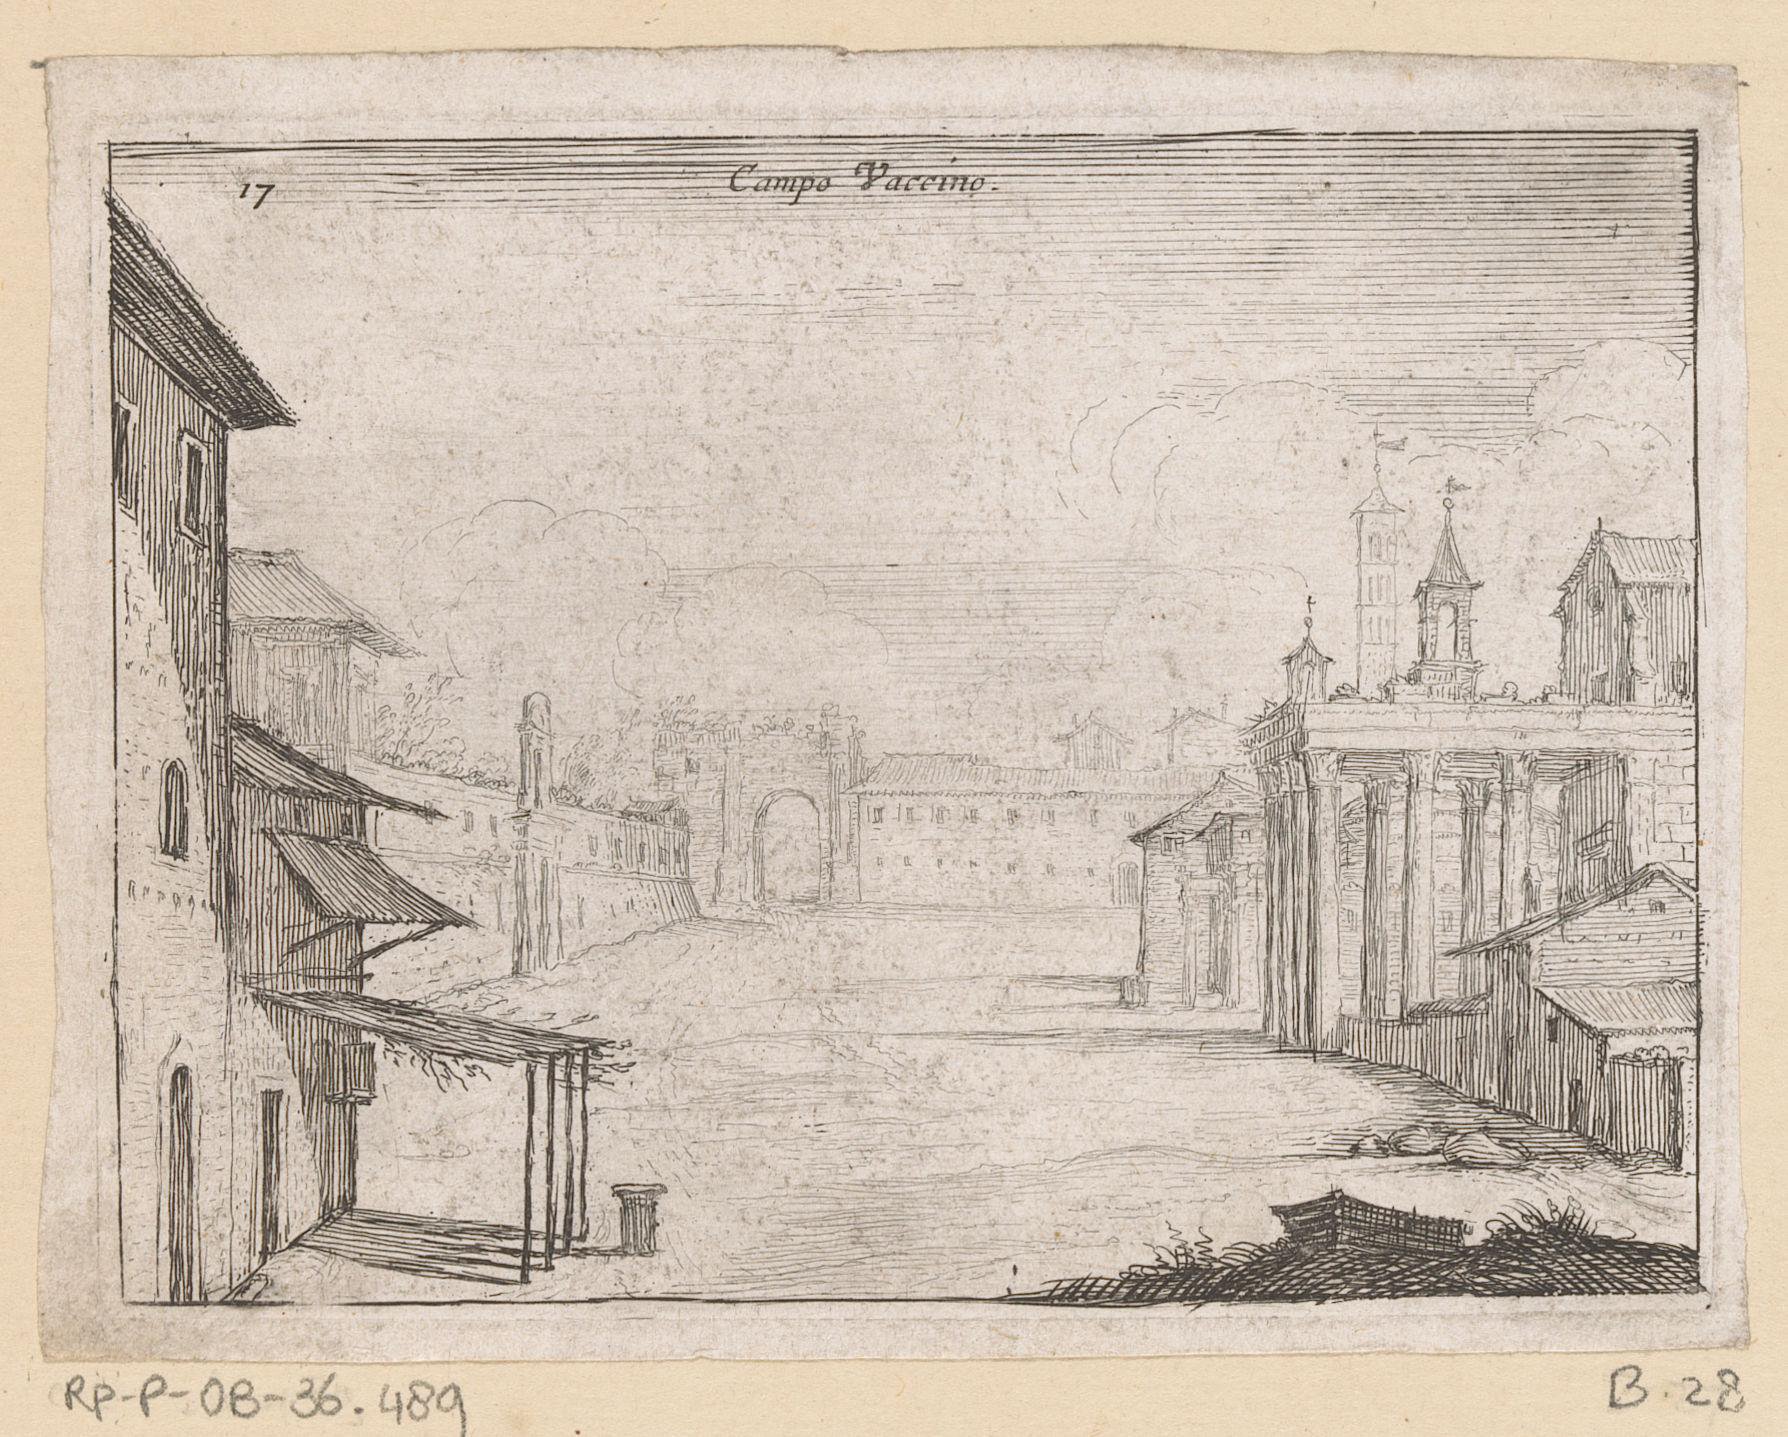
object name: print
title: Gezicht op het Forum Romanum te Rome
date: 1629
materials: paper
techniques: etching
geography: tuscany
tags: landscape with ruins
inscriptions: collector's mark: Lugt 2228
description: Deze prent maakt deel uit van een reeks van 52 prenten.